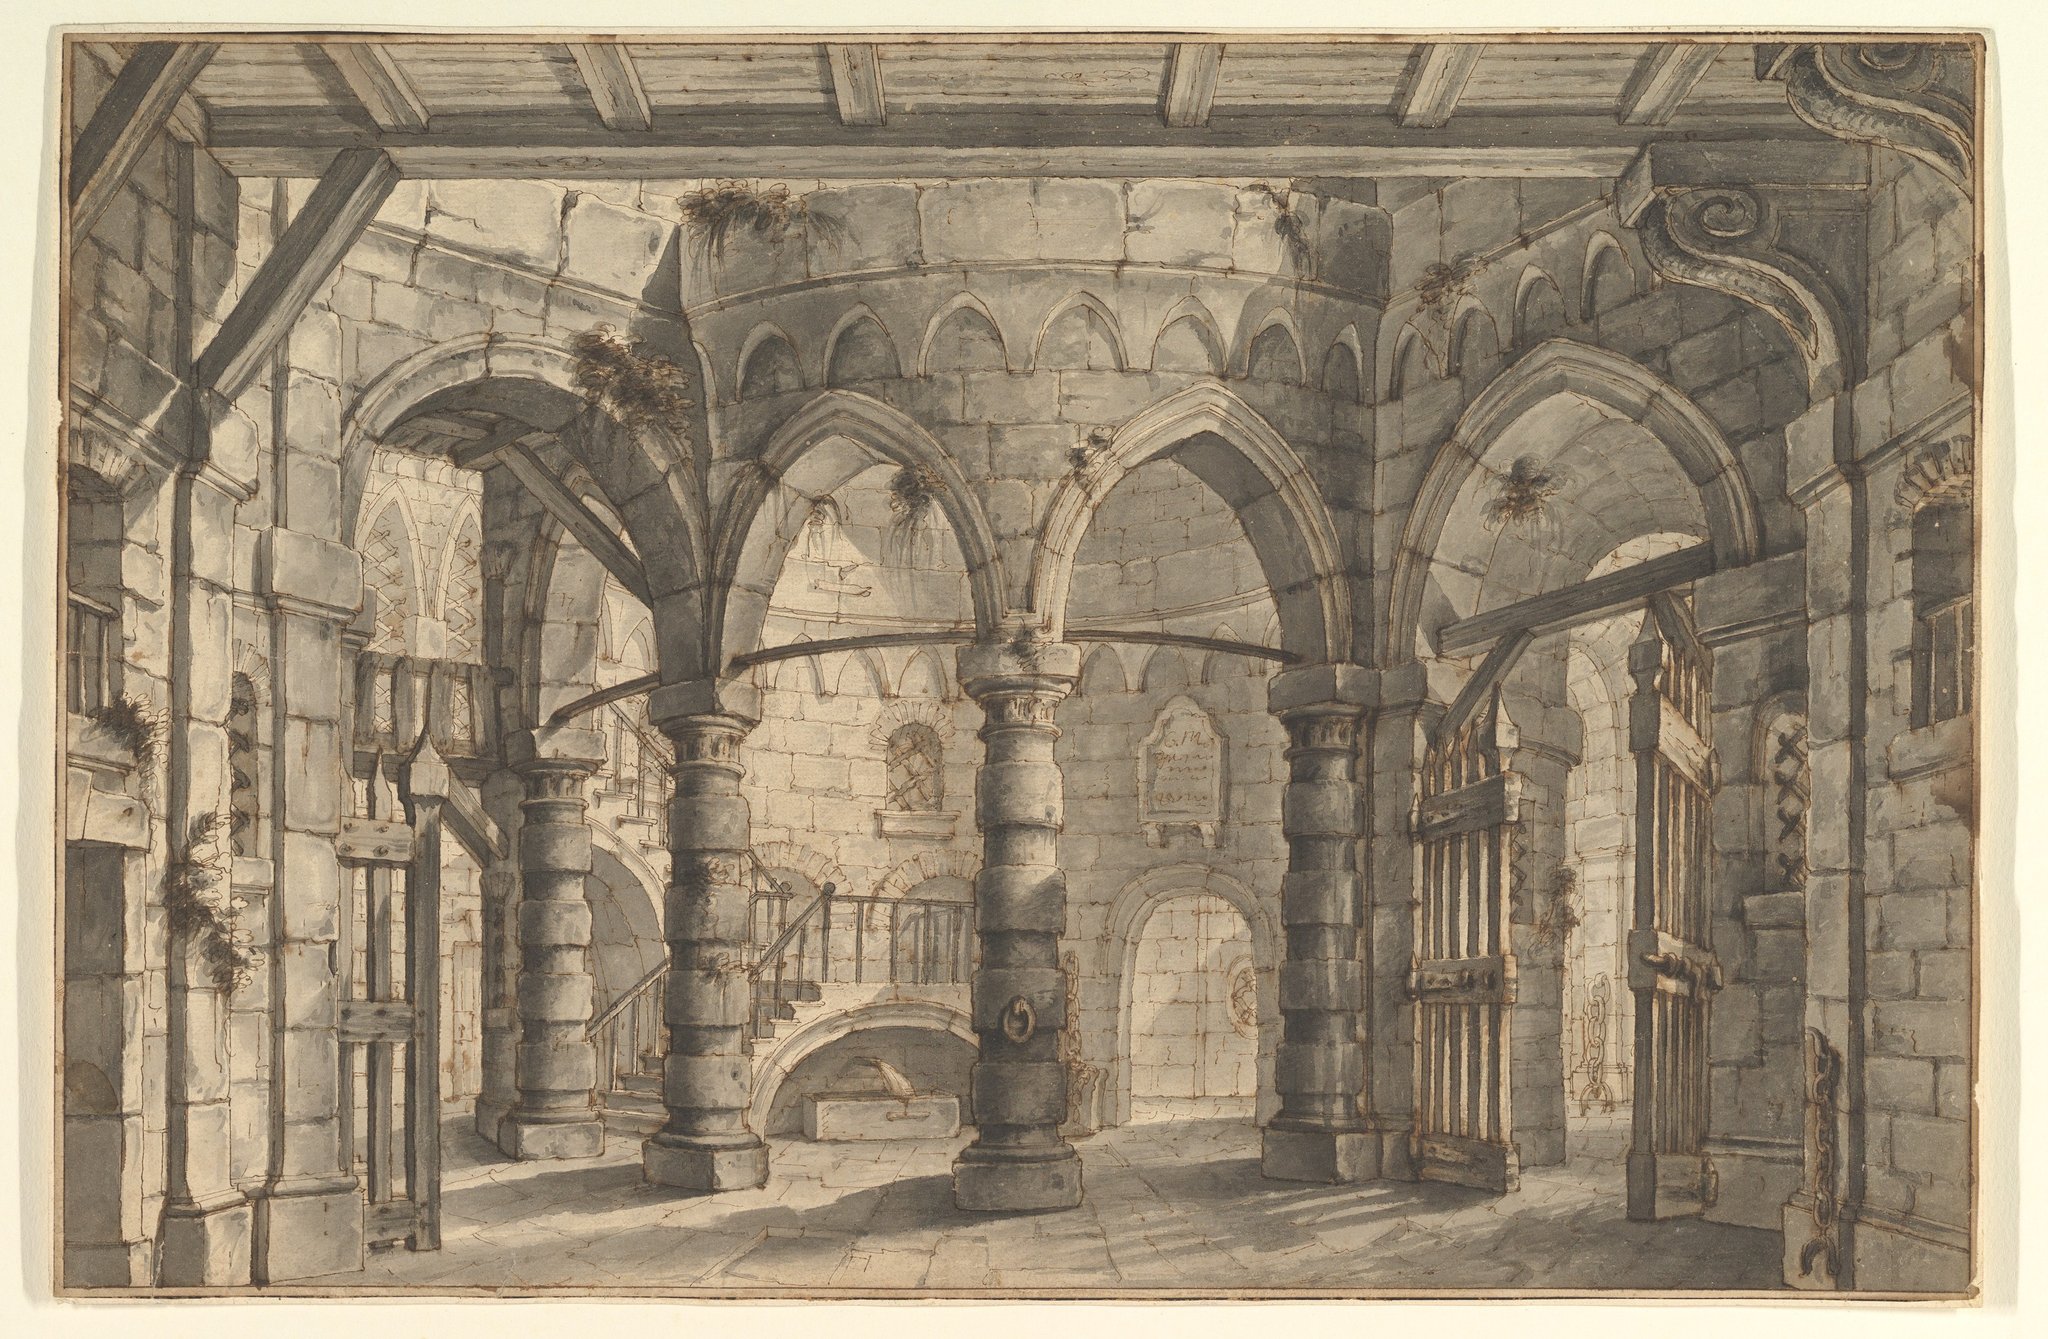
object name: drawing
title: Design for a Stage Set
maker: giovanni maria quaglio i (also known as giulio quaglio iii)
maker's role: artist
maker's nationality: italian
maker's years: 1700-1765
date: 1700-1765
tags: arches,columns,stage design